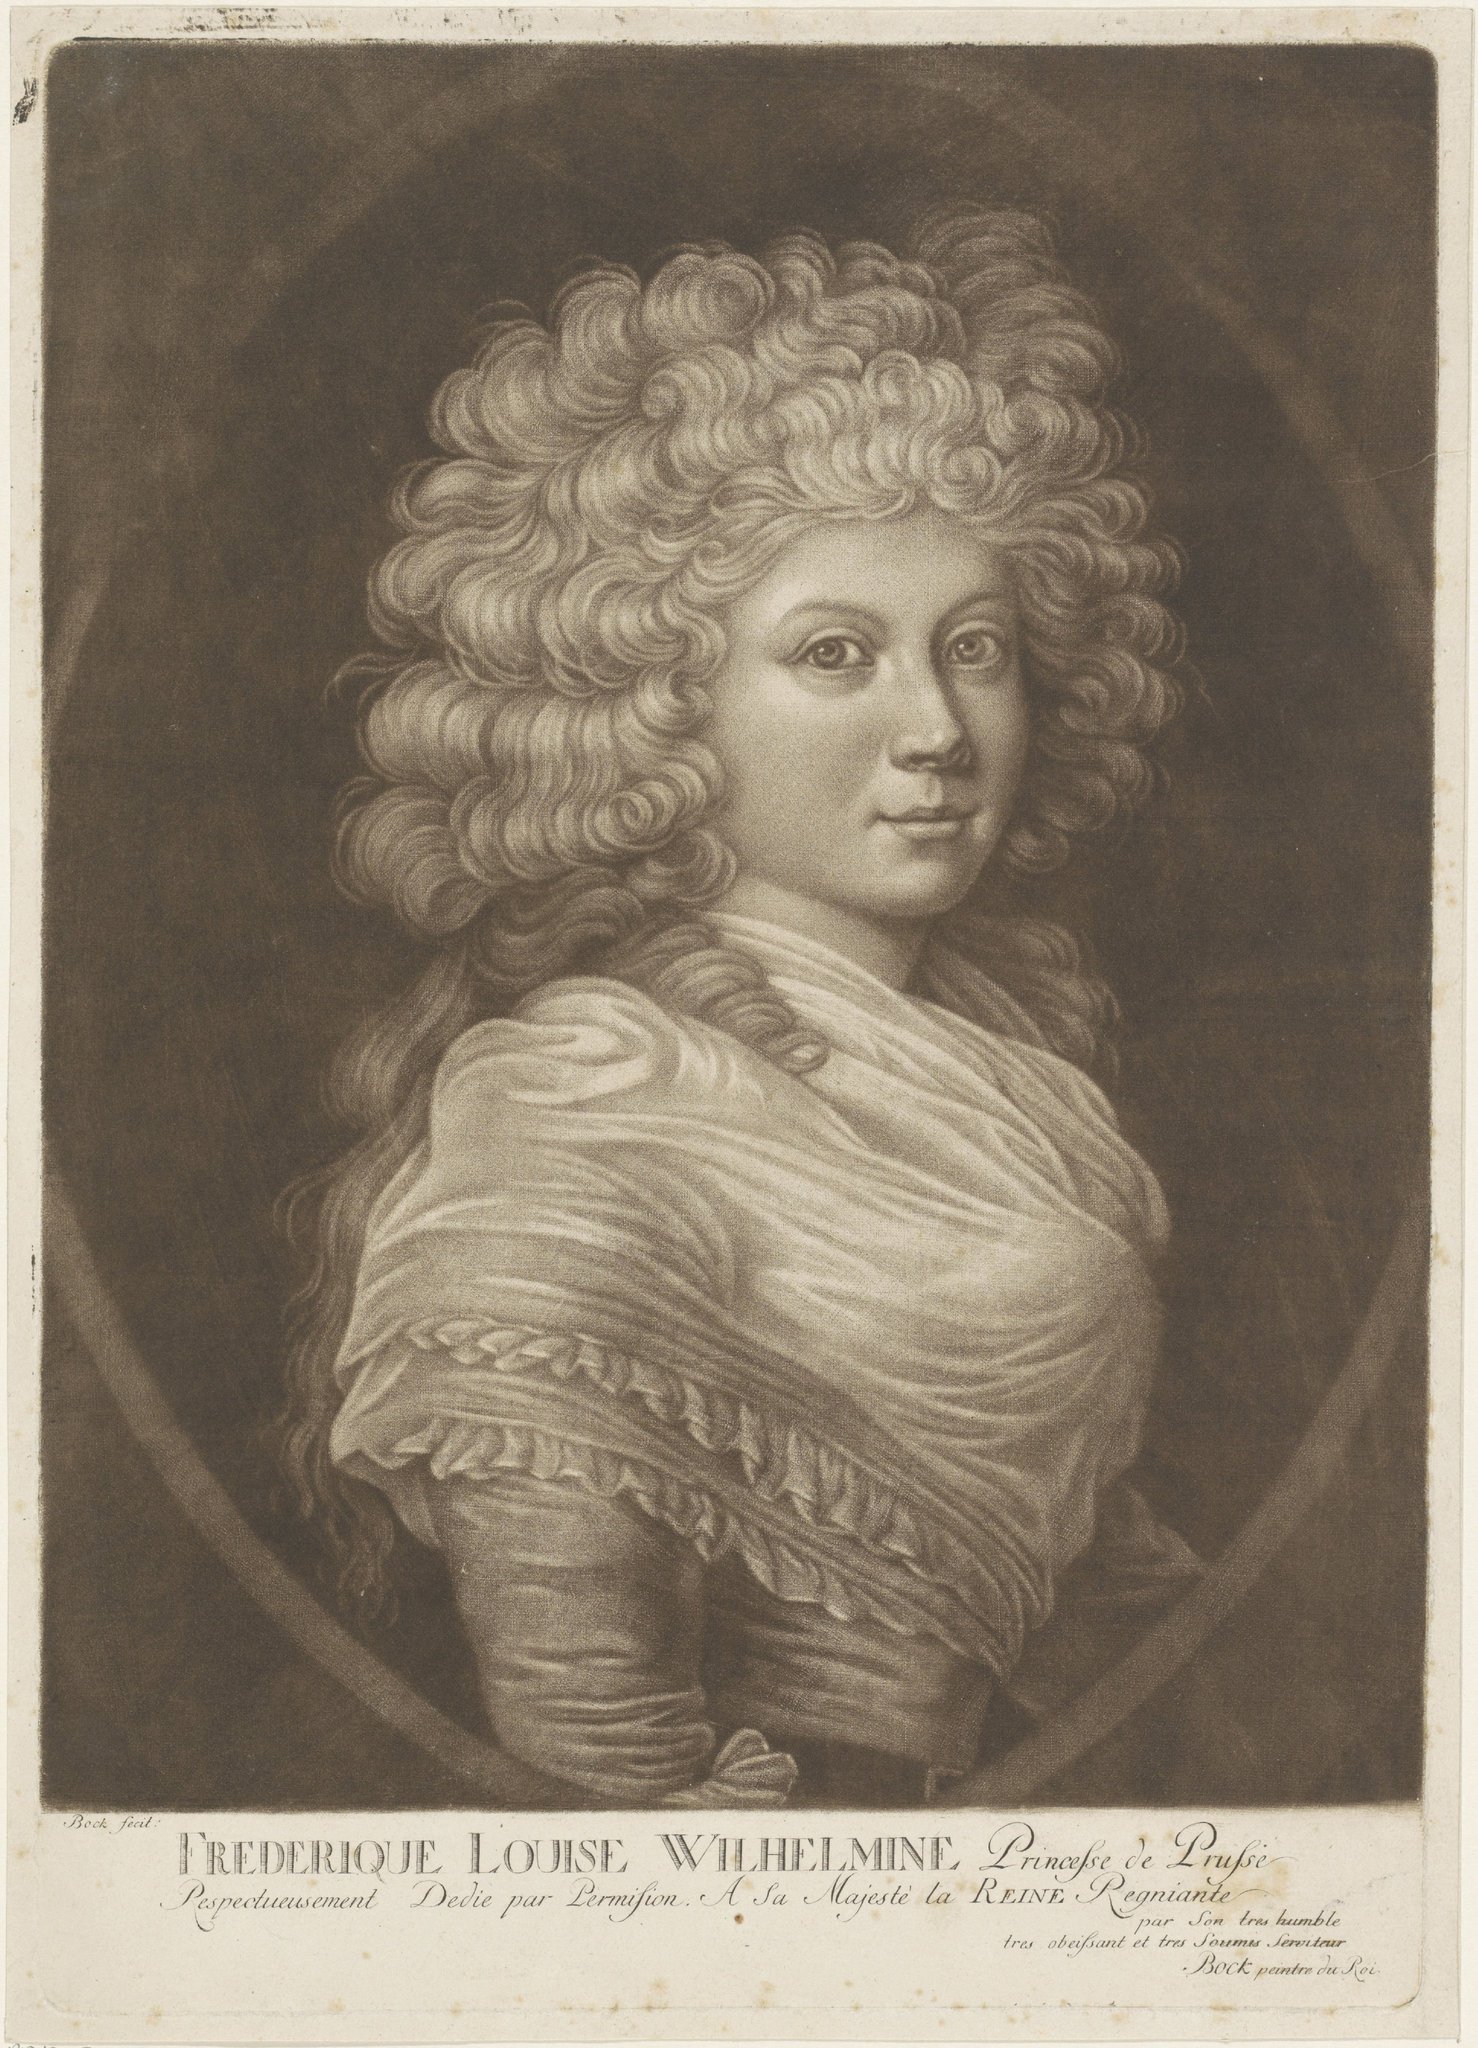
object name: print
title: Portret van Wilhelmina van Pruisen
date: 1790-1829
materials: paper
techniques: mezzotint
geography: berlin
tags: berlin, the hague, wilhelmina frederica louisa (koningin der nederlanden)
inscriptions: collector's mark: Lugt 2165, collector's mark: Lugt 963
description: Portret van Wilhelmina in een ovaal. In de ondermarge haar naam en titel.